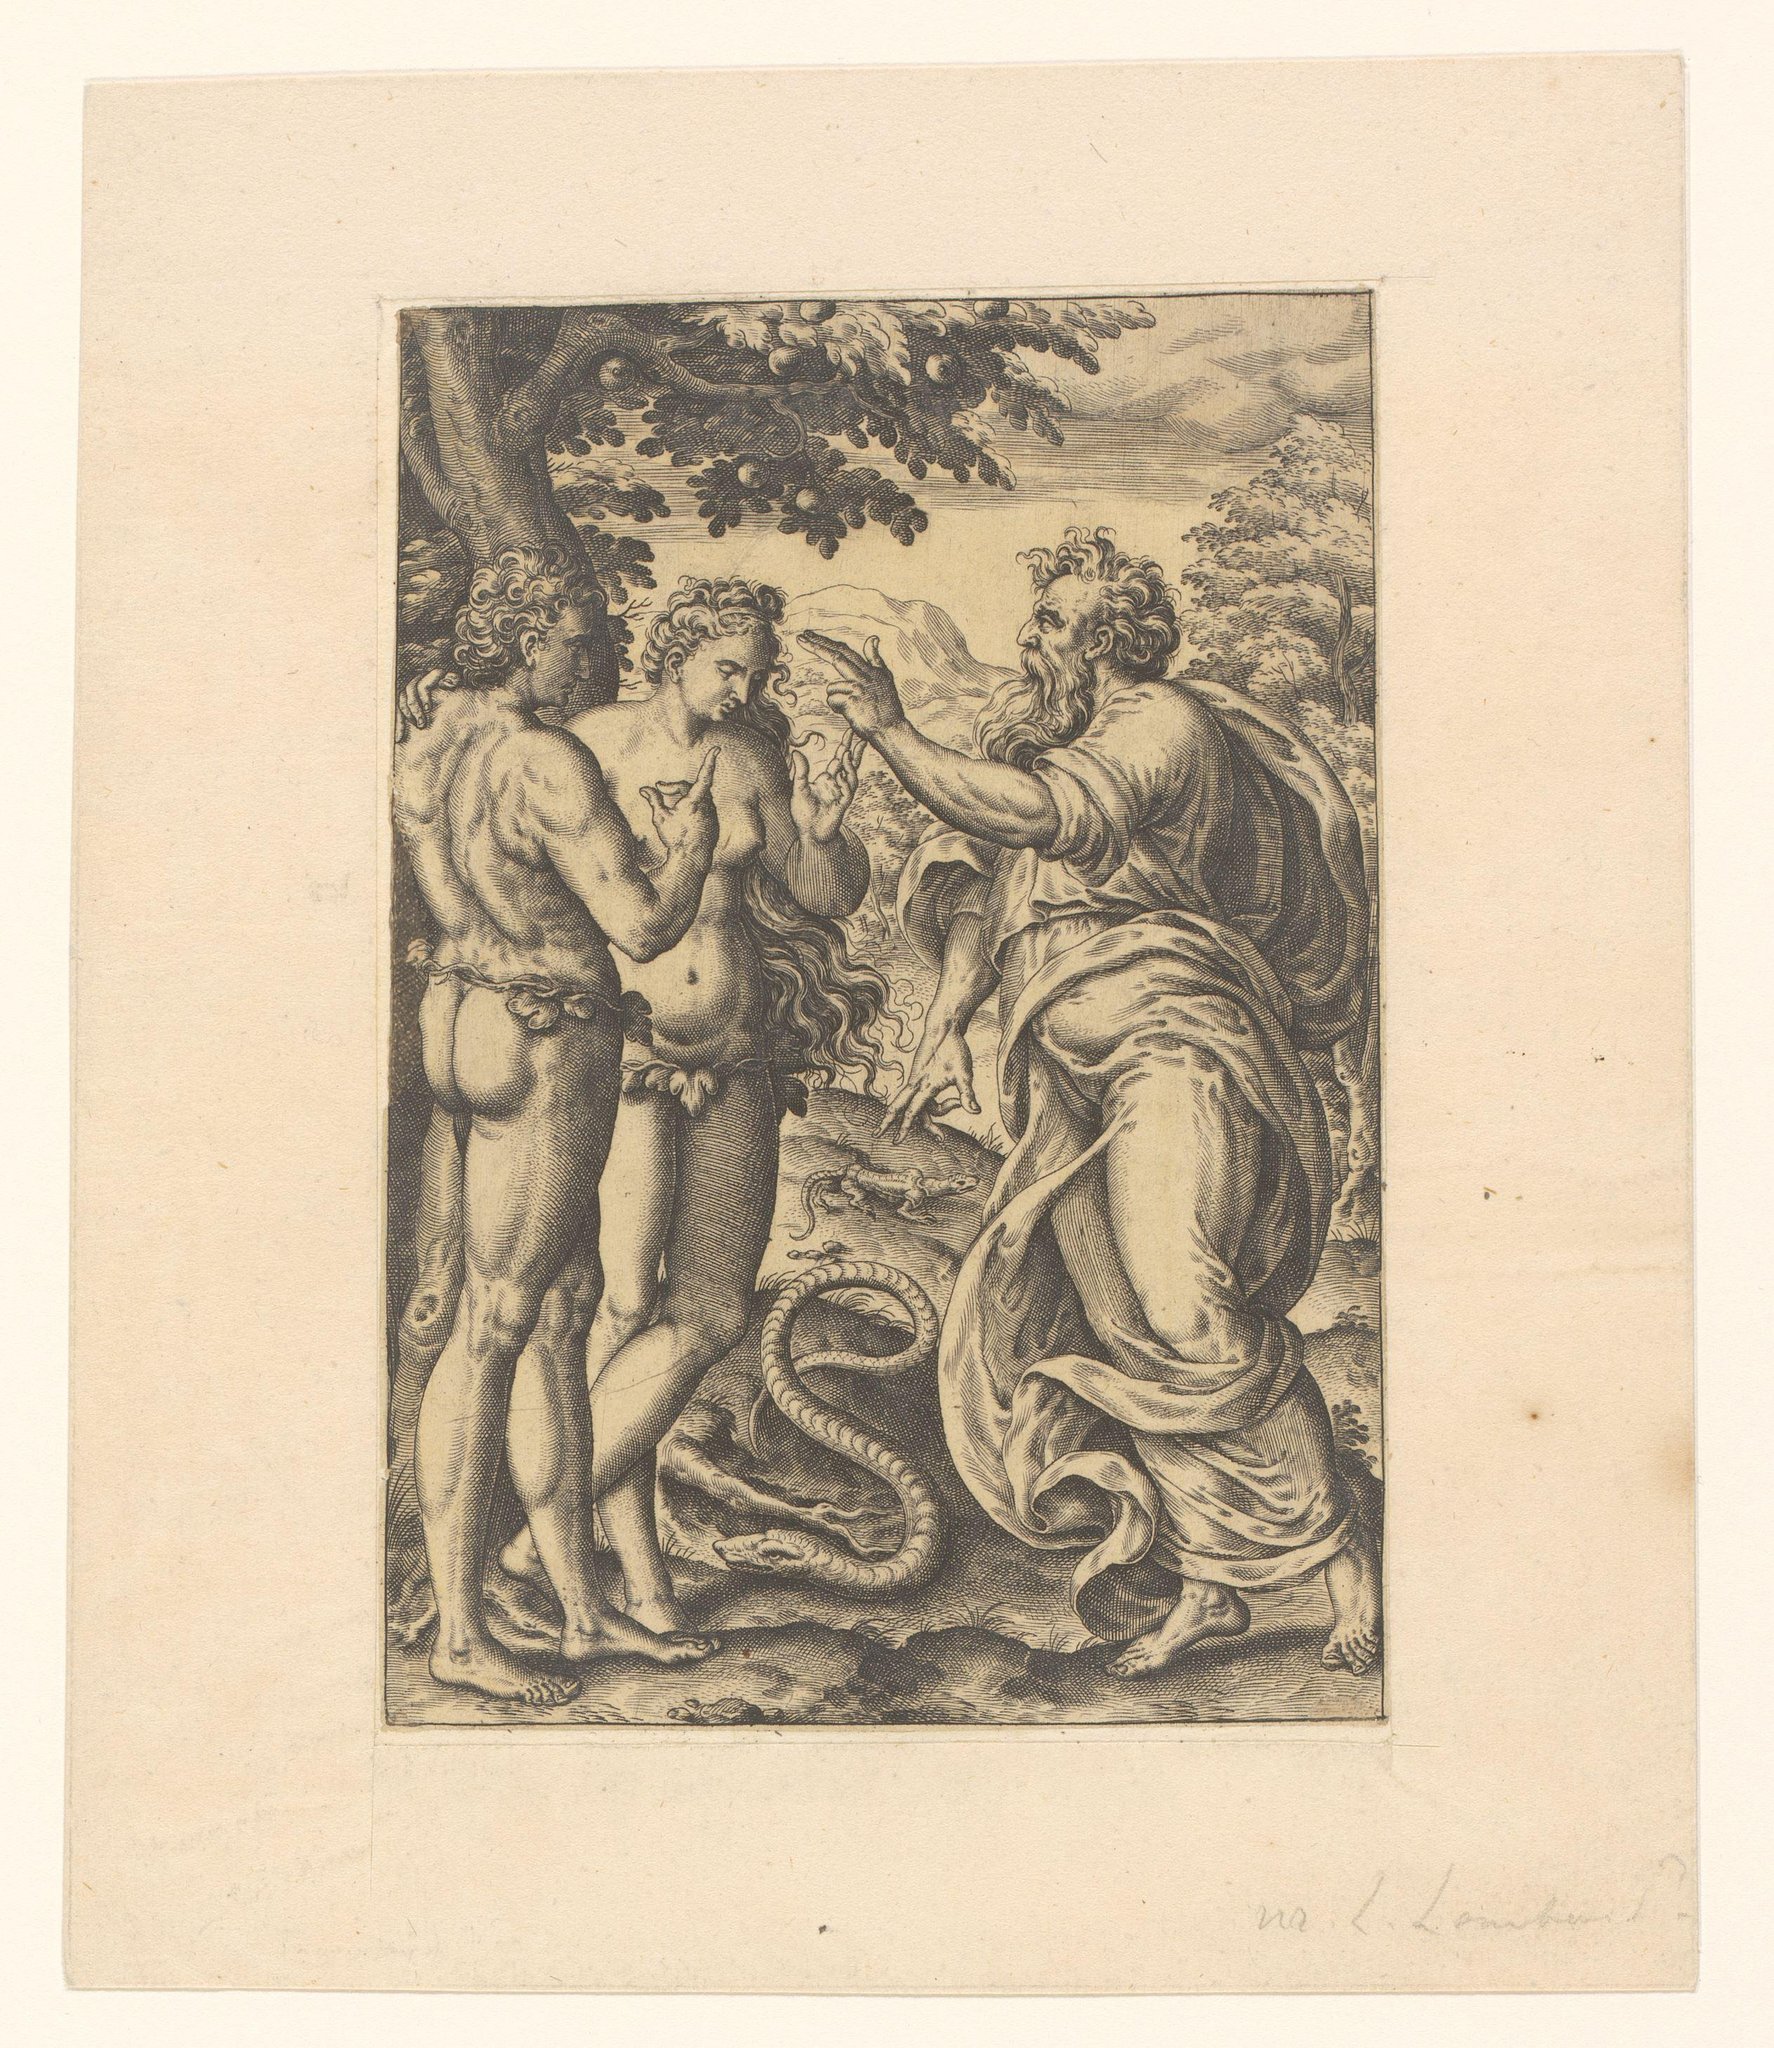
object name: print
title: God roept Adam en Eva ter verantwoording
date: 1583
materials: paper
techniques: engraving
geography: antwerp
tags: adam and eve reproved by god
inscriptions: inscription: ‘31.2.-A.’, collector's mark: Lugt 240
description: Als illustratie gebruikt in: Montano, Benito Arias. Humanae salutis monumenta. Antwerpen: Christopher Plantijn, 1583.